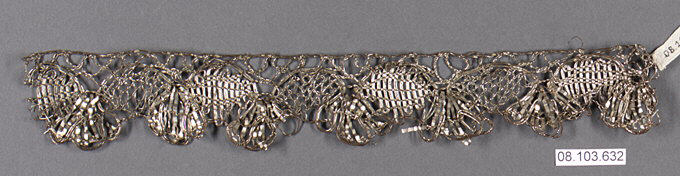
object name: piece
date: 1701-1900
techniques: lace